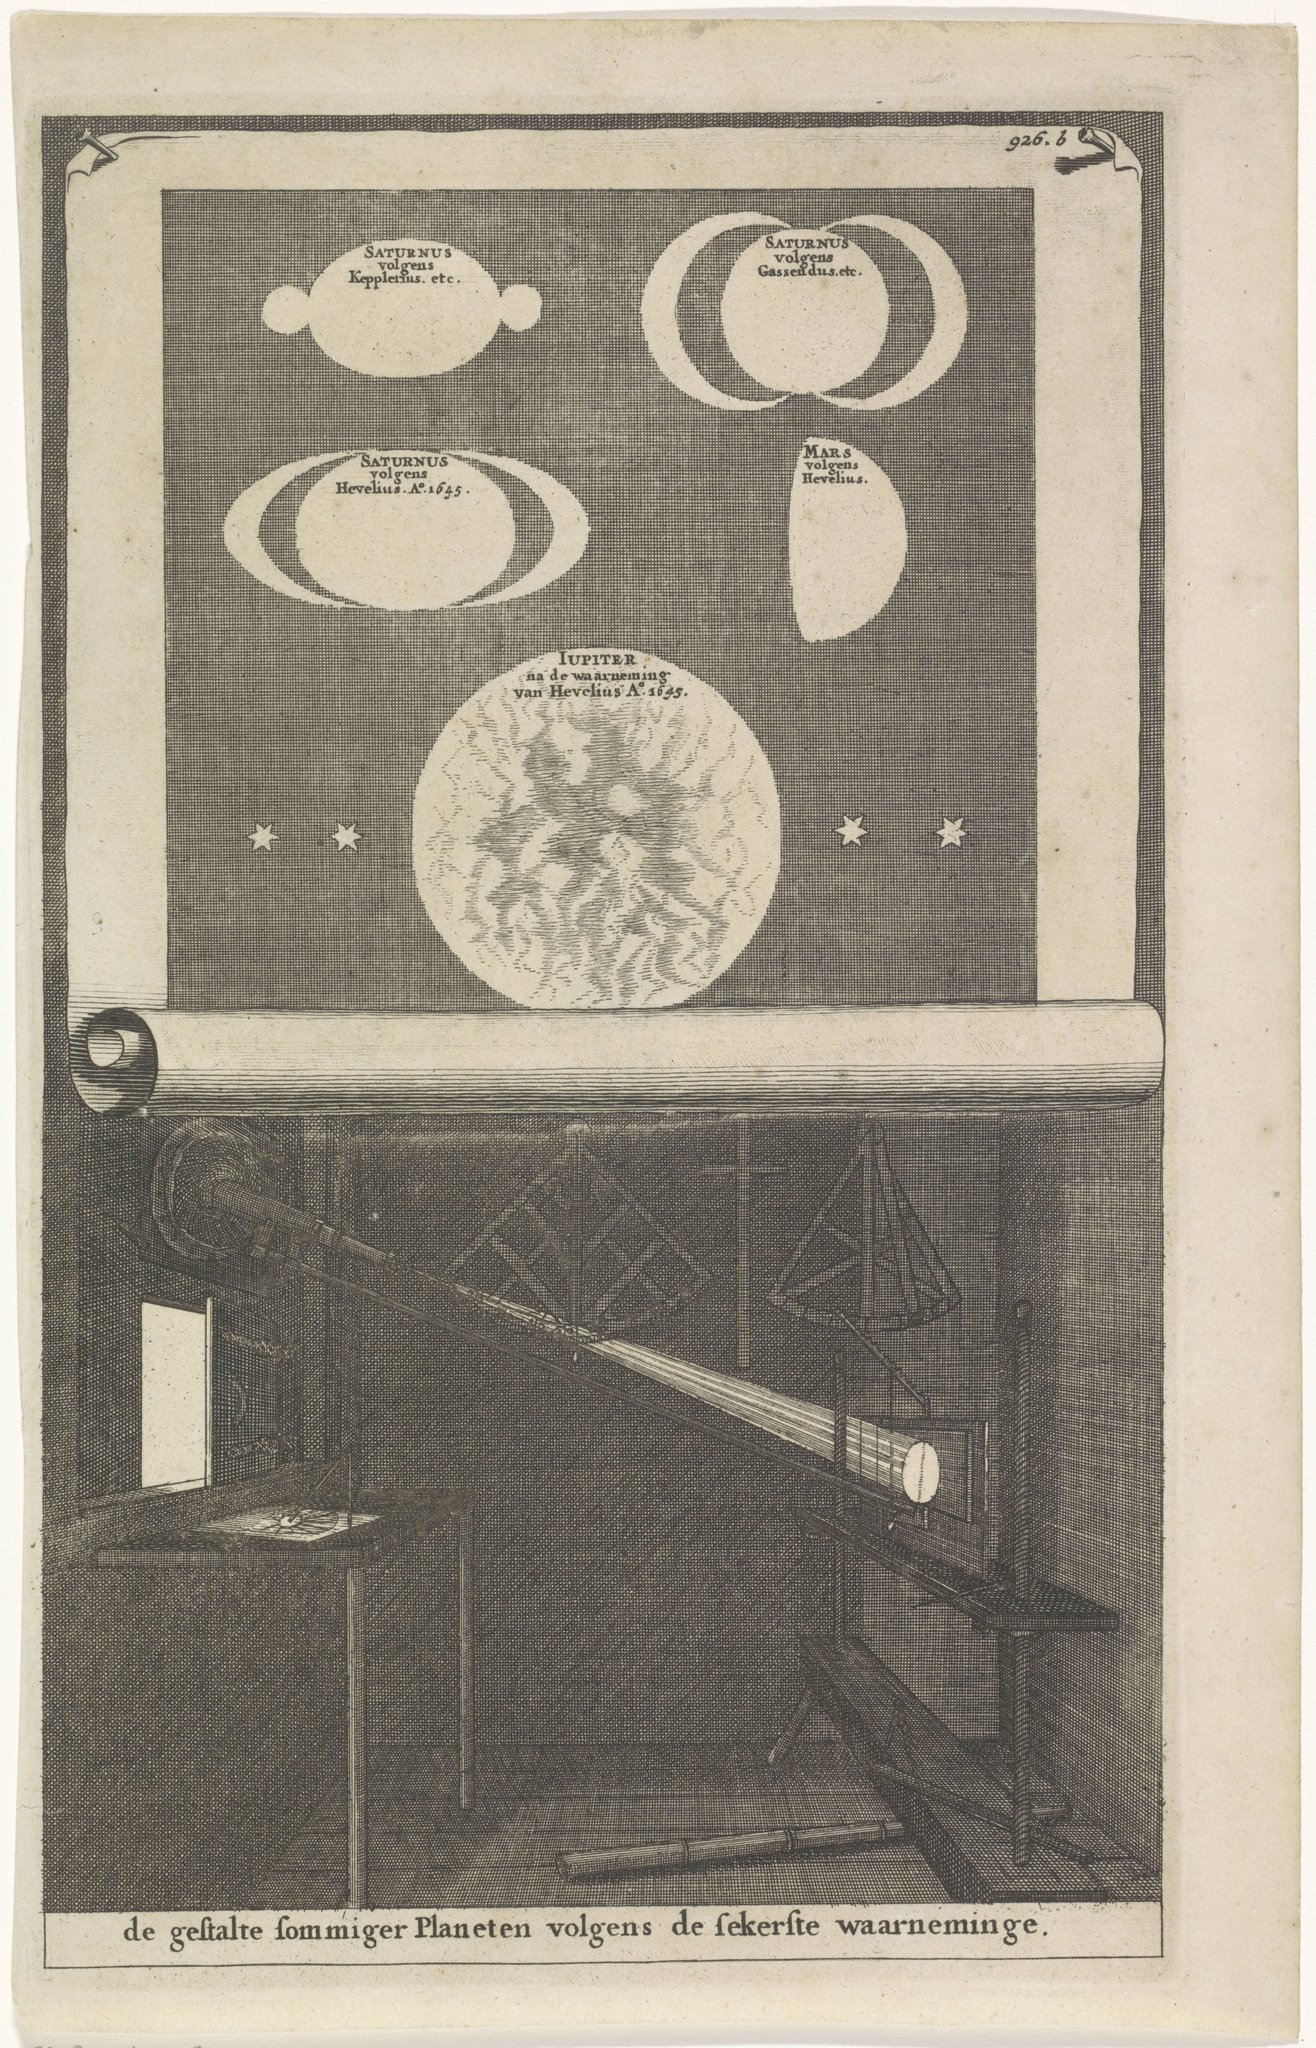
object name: print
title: Planeten en een telescoop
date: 1690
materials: paper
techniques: etching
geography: amsterdam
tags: telescope, planets; planetary system, solar system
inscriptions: collector's mark: Lugt 2228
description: De planeten Saturnus, Mars en Jupiter, zoals zij zijn geobserveerd door Kepplerius, Gassendus en Hevelius, op een opgeprikt papier. Daaronder is een kamer zichtbaar met sterrenkundige instrumenten. Rechtsboven genummerd: 926 b.